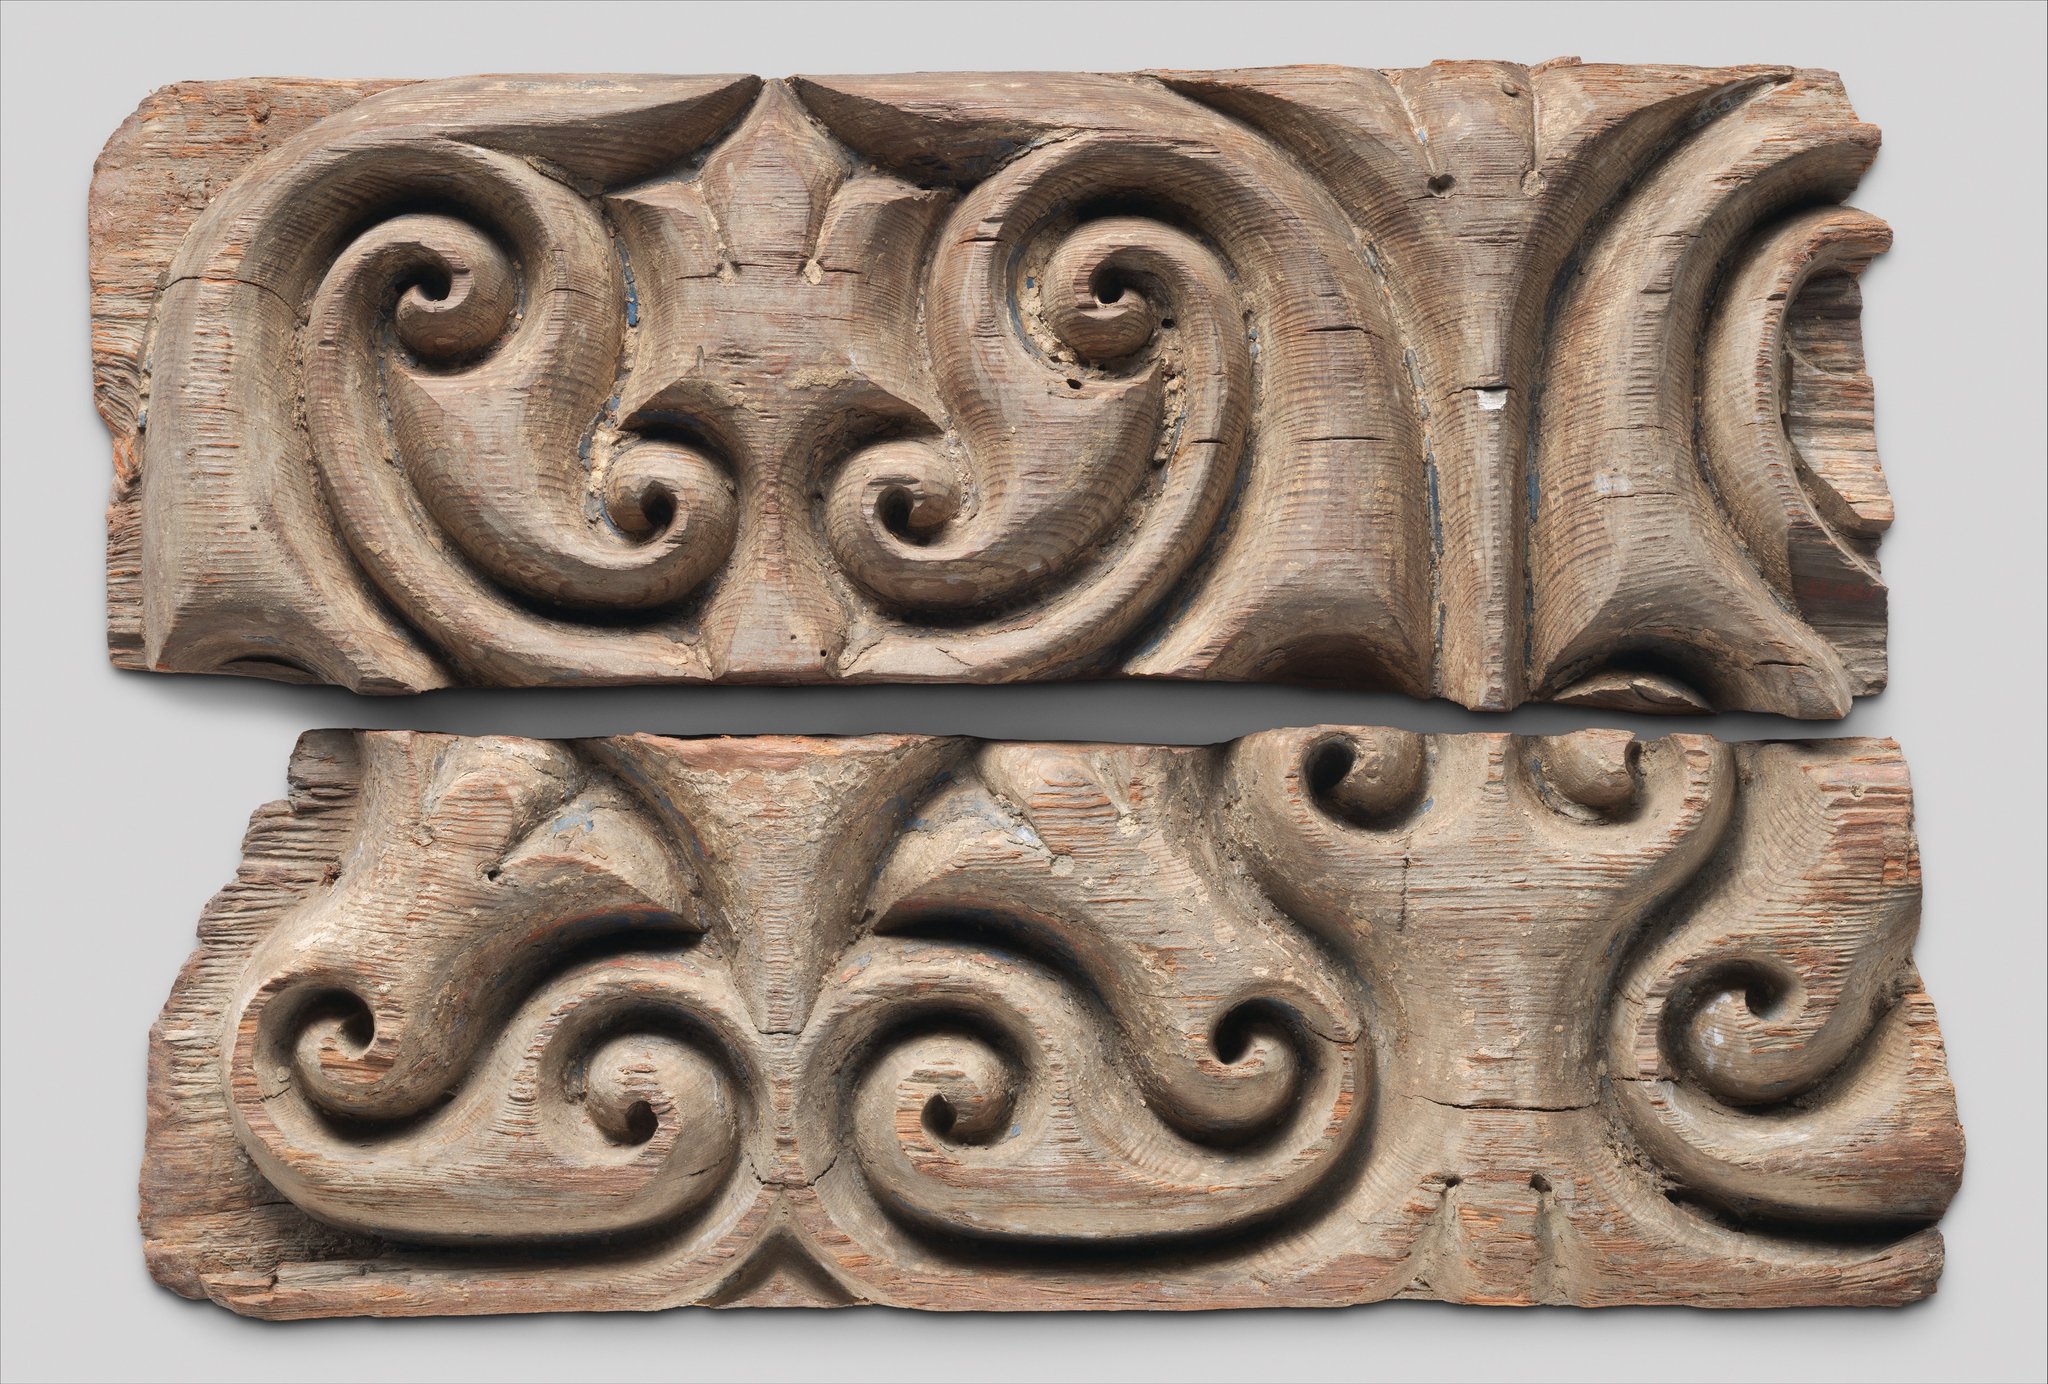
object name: panel fragment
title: Panel Carved in the "Beveled Style" with Remains of Later Polychromy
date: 976-1000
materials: wood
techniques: carving, gilding, painting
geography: egypt